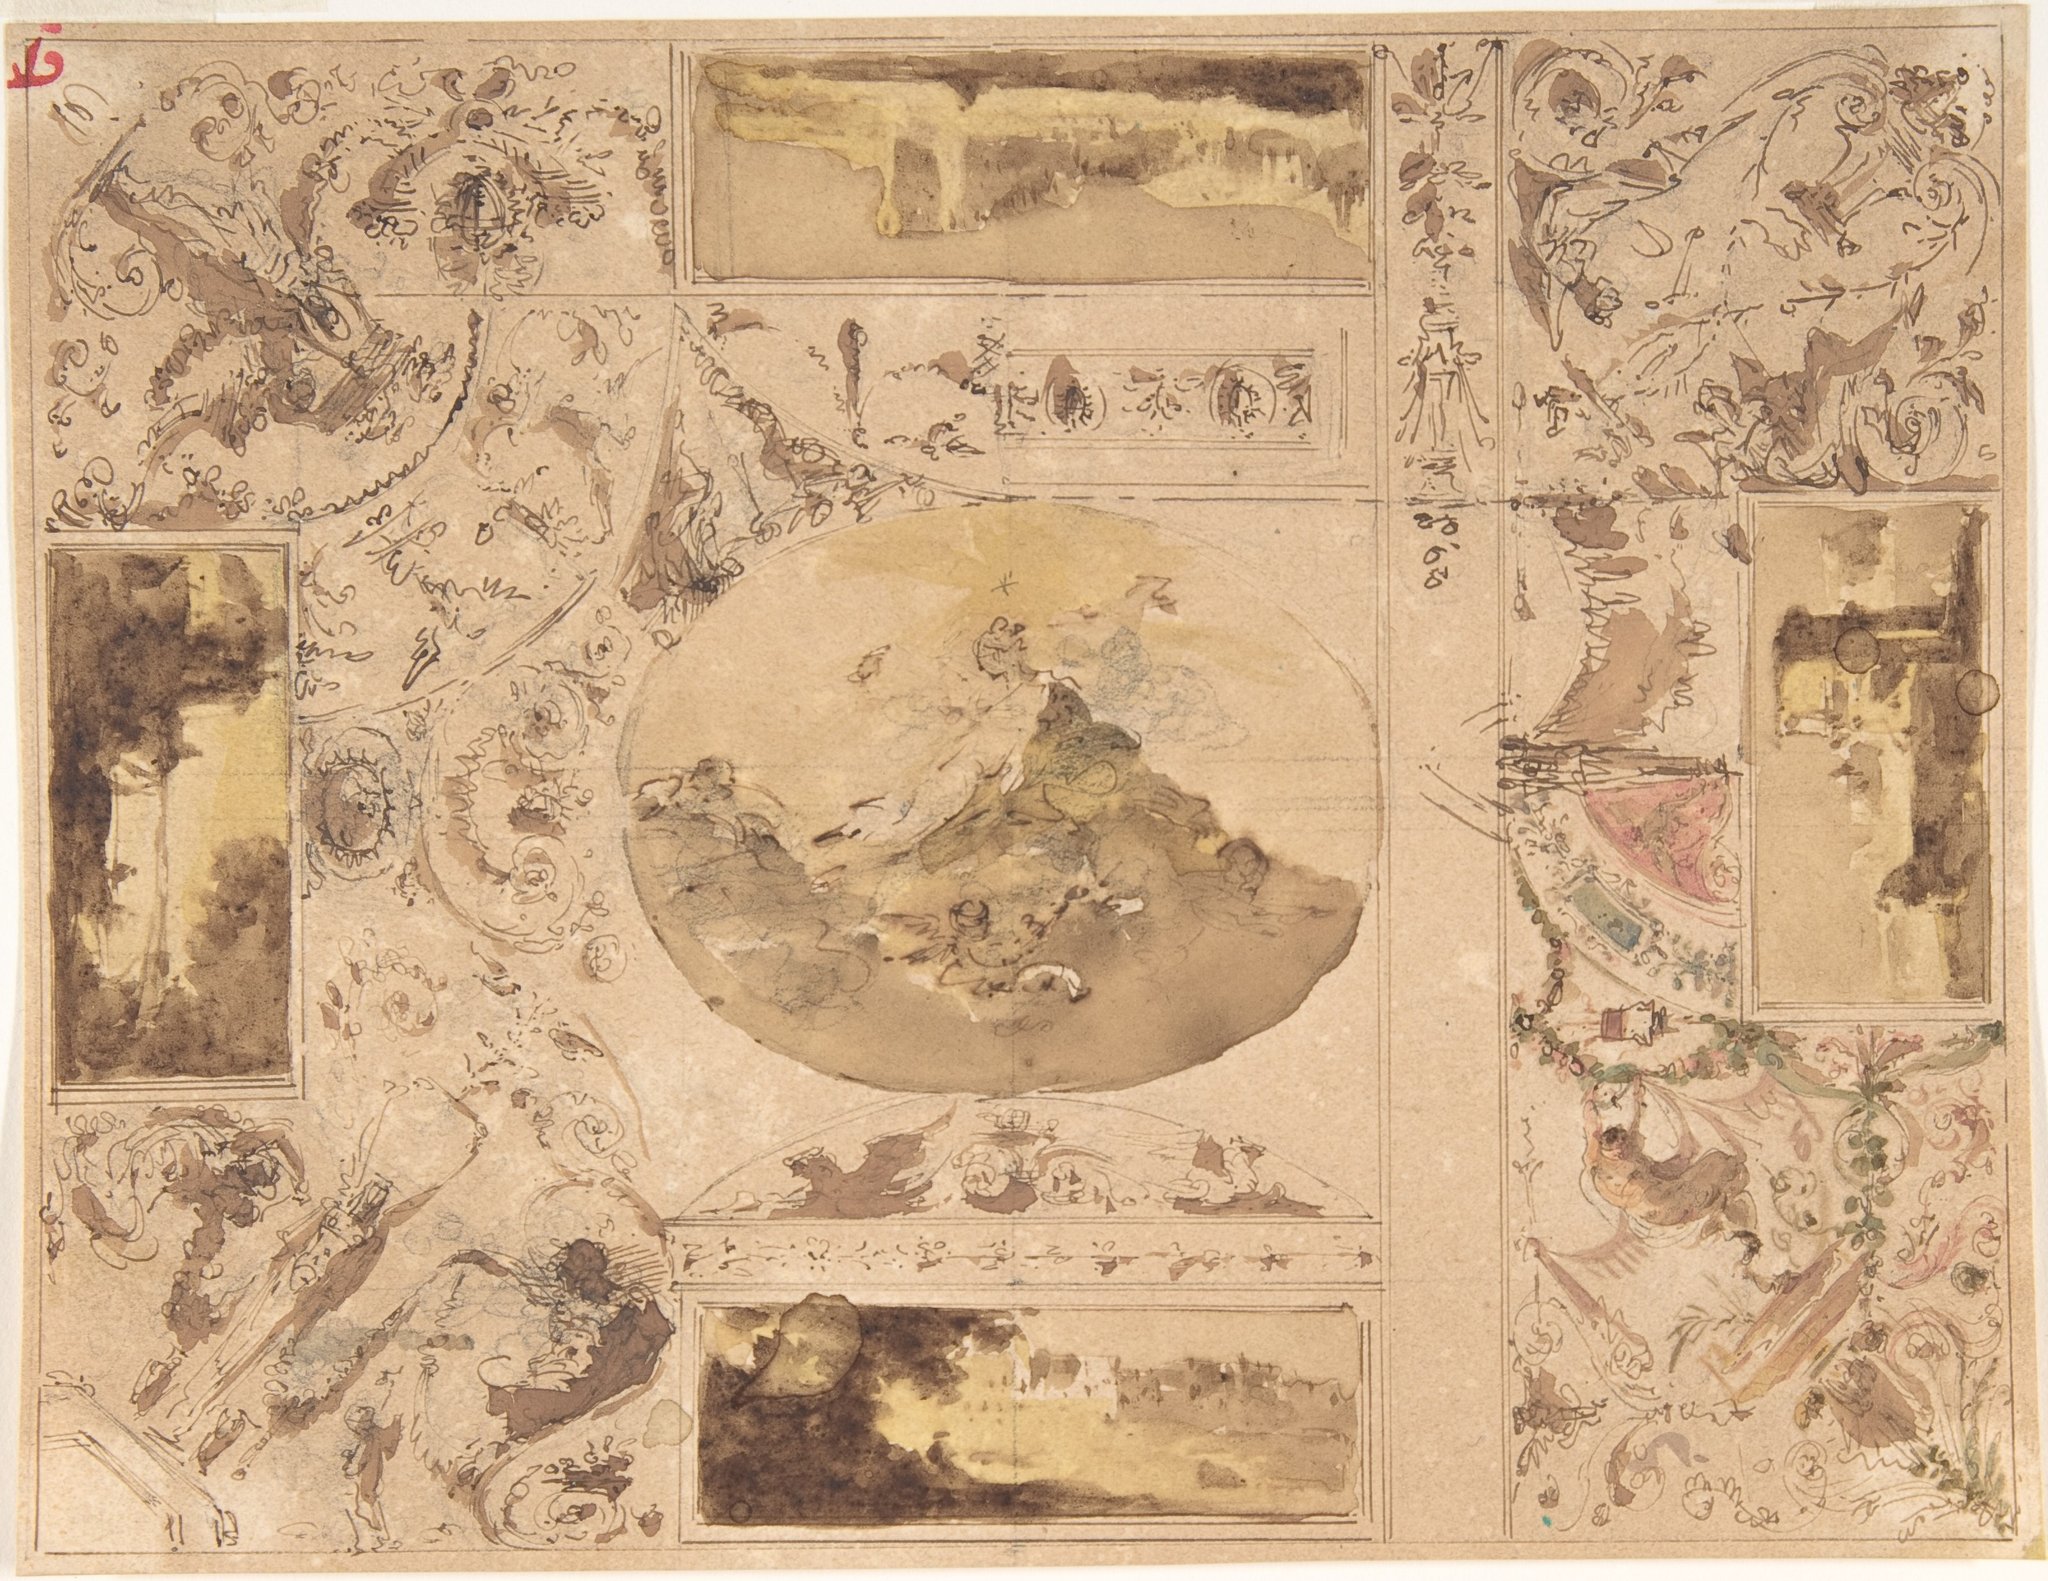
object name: drawing ornament architecture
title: Designs for the decoration of a ceiling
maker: giuseppe bernardino bison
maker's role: artist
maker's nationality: italian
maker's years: 1762-1844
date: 1767-1866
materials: graphite, ink, watercolor, paper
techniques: brush, pen, wash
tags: ceilings